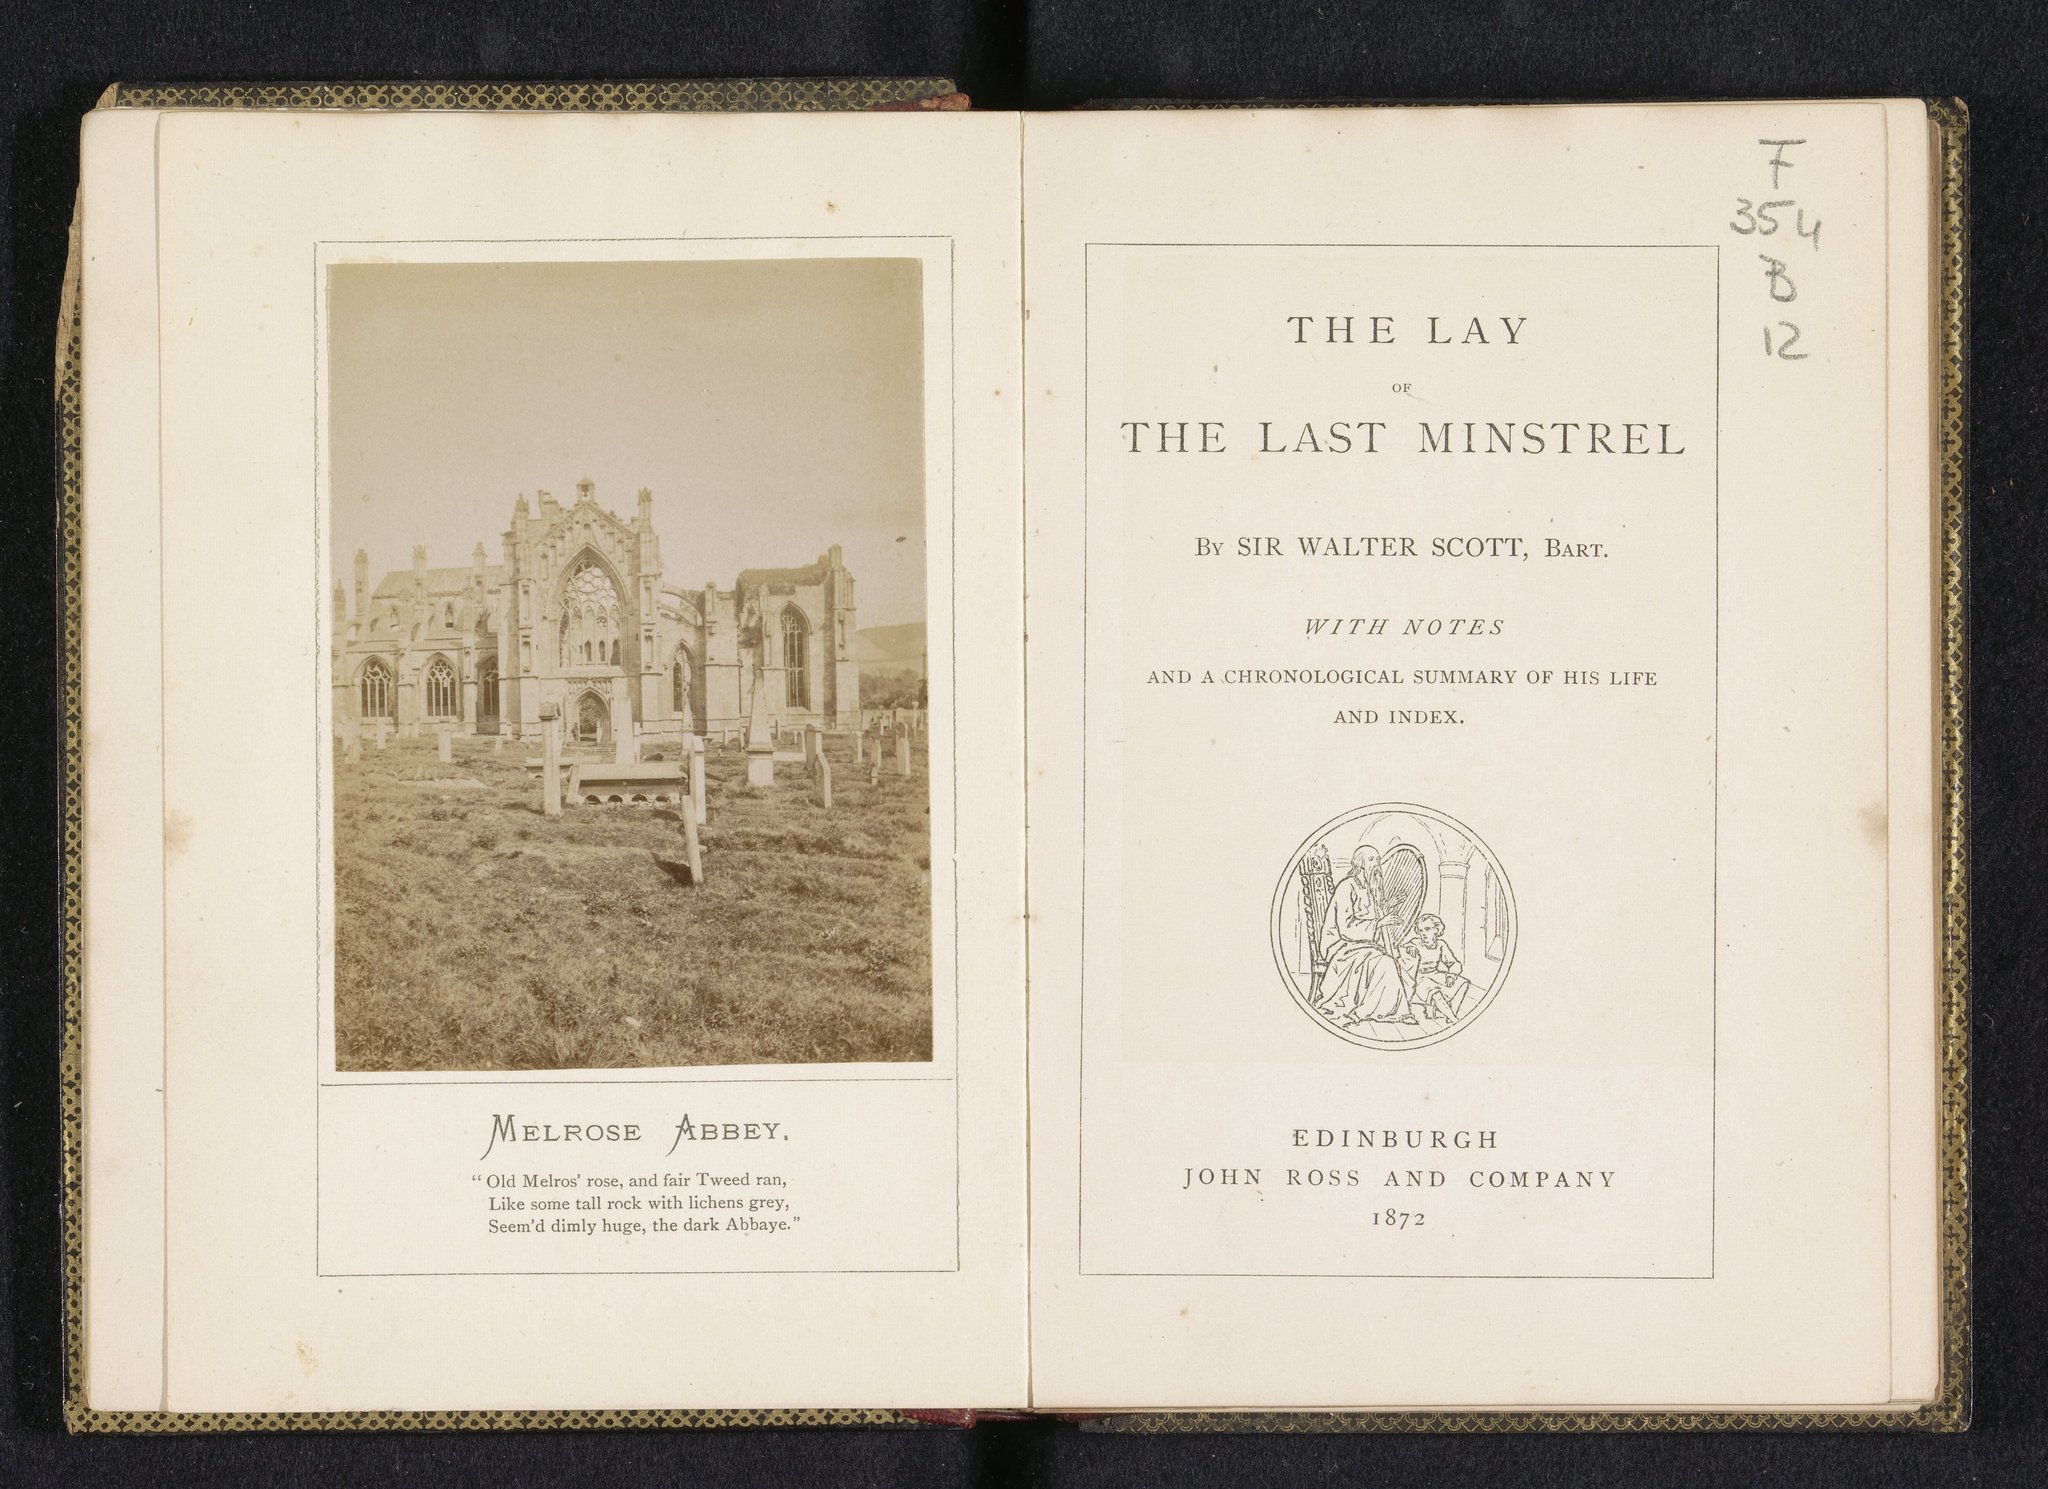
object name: book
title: The lay of the last minstrel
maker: walter scott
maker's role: dichter, schrijver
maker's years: 1771-1832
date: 1872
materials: cardboard, paper, photographic support, wood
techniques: albumen print, printing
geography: edinburgh